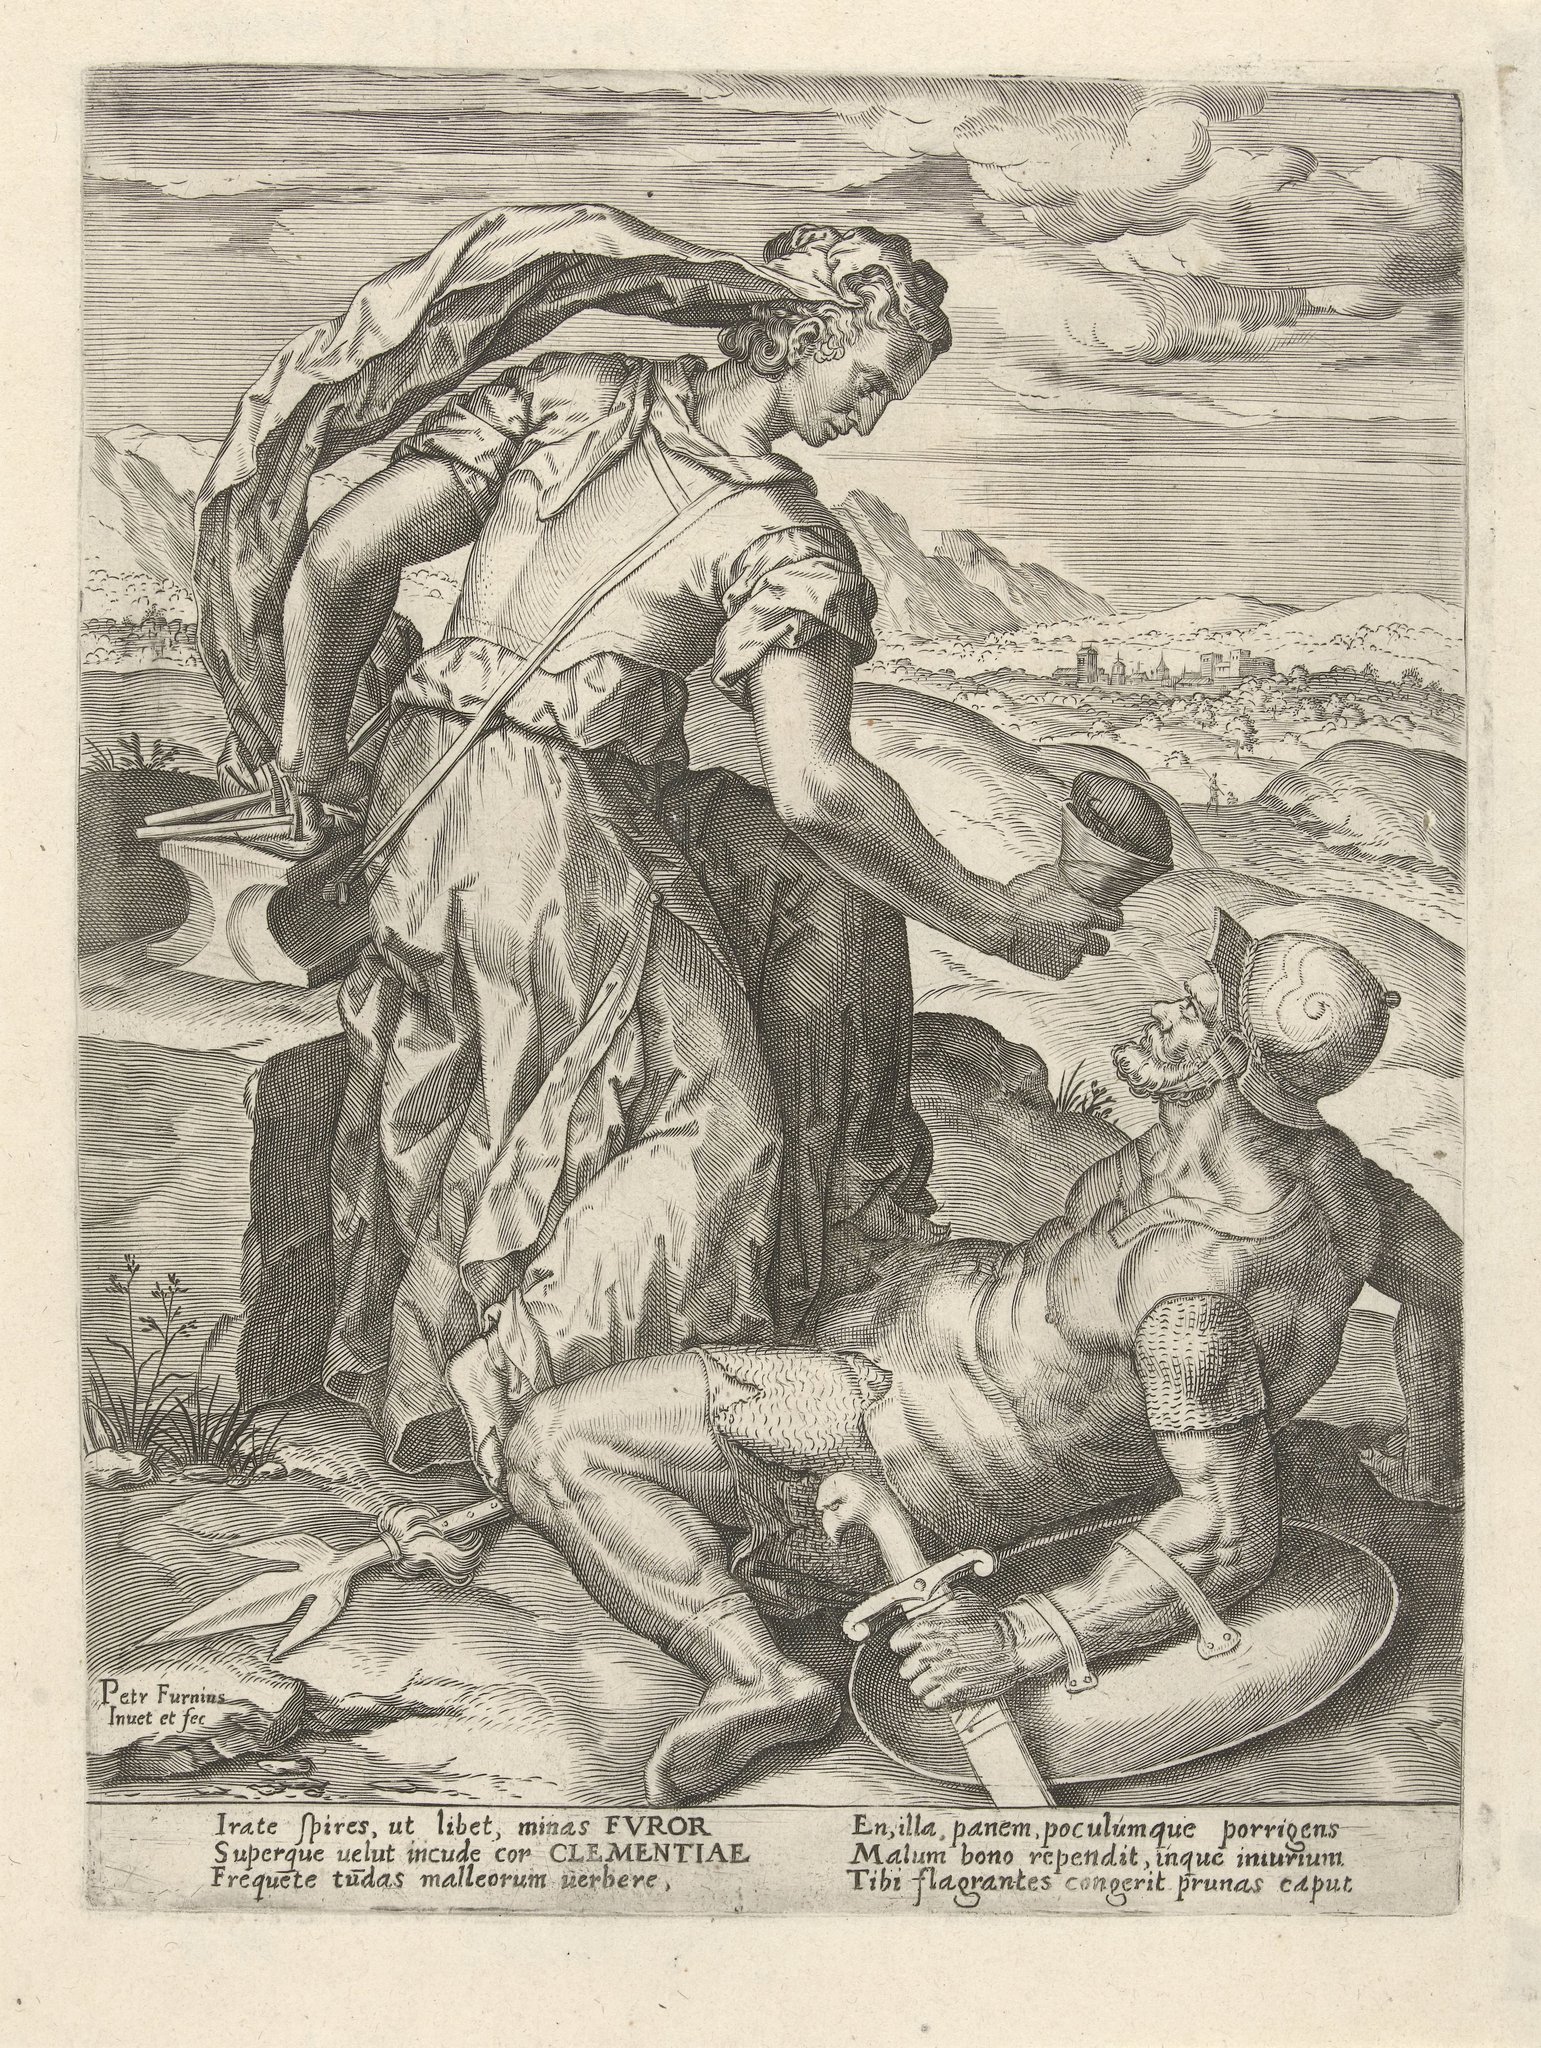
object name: print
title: Zachtmoedigheid overwint Razernij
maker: pieter jalhea furnius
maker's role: print maker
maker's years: 1540-1626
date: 1550-1625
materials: paper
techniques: engraving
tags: anger; 'ira' (ripa) ~ personification of one of the seven deadly sins, one virtue fighting against or treading upon one vice, indulgence, clemency; 'clemenza', 'clemenza & moderatione', 'indulgenza' (ripa)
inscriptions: collector's mark: Lugt 2228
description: De personificatie van Razernij (Furor) ligt op de grond aan de voeten van Zachtmoedigheid (Clementia). De prent heeft een Latijns onderschrift en maakt deel uit van een serie over deugden en ondeugden.